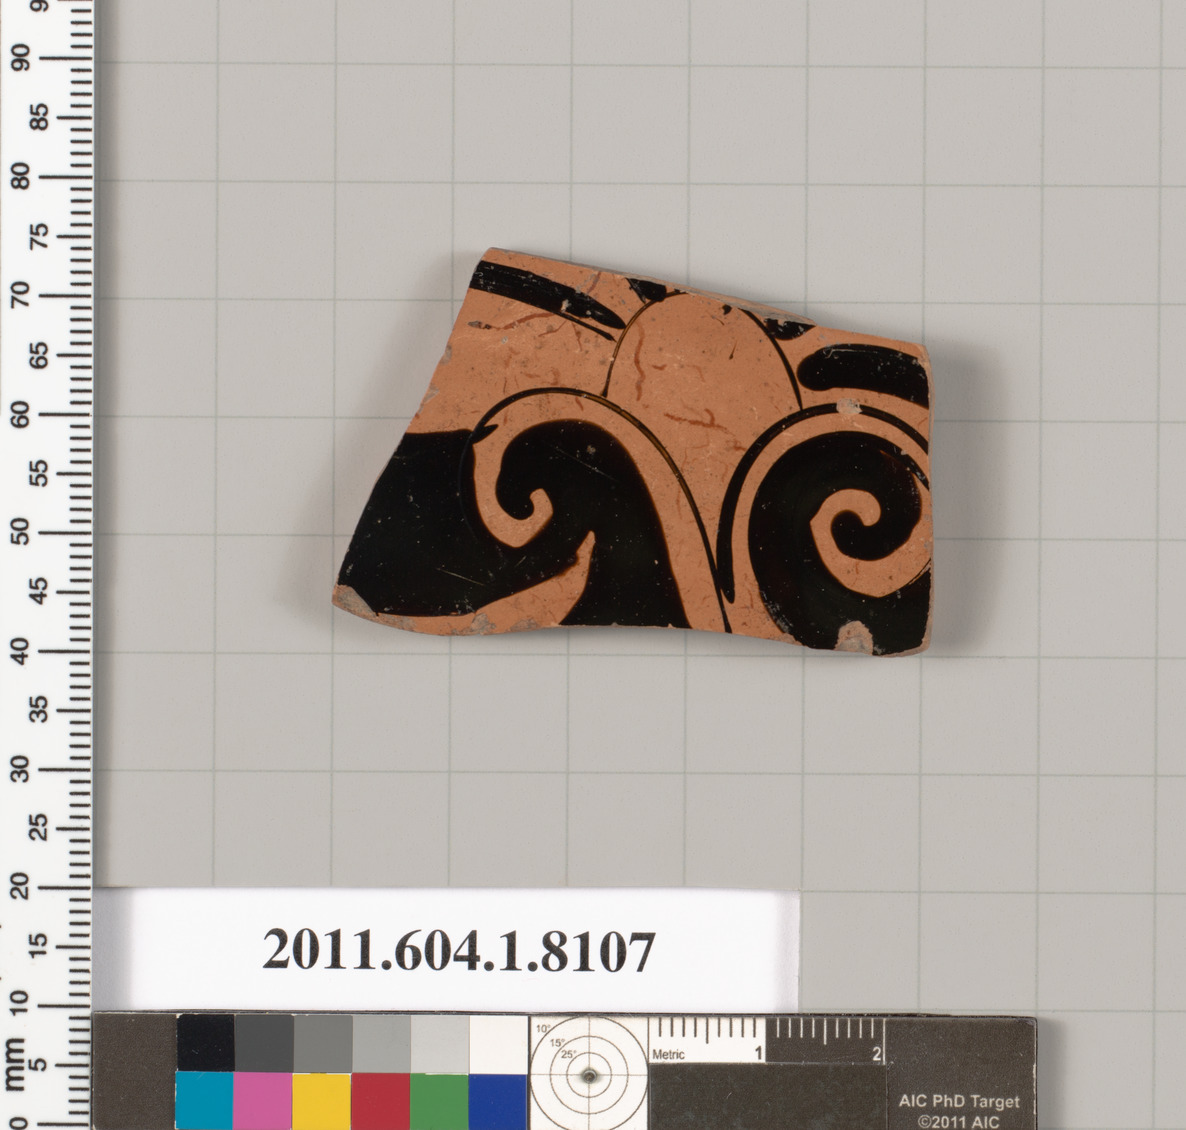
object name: kylix fragment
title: Terracotta fragment of a kylix (drinking cup)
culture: greek, attic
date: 520-510 BCE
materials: terracotta